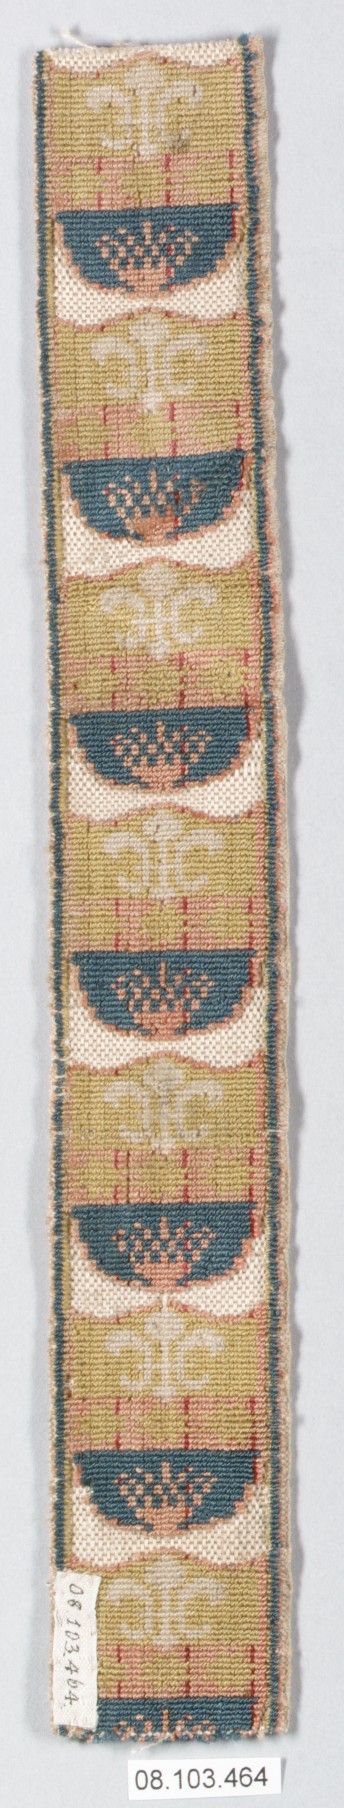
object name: galloon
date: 1701-1800